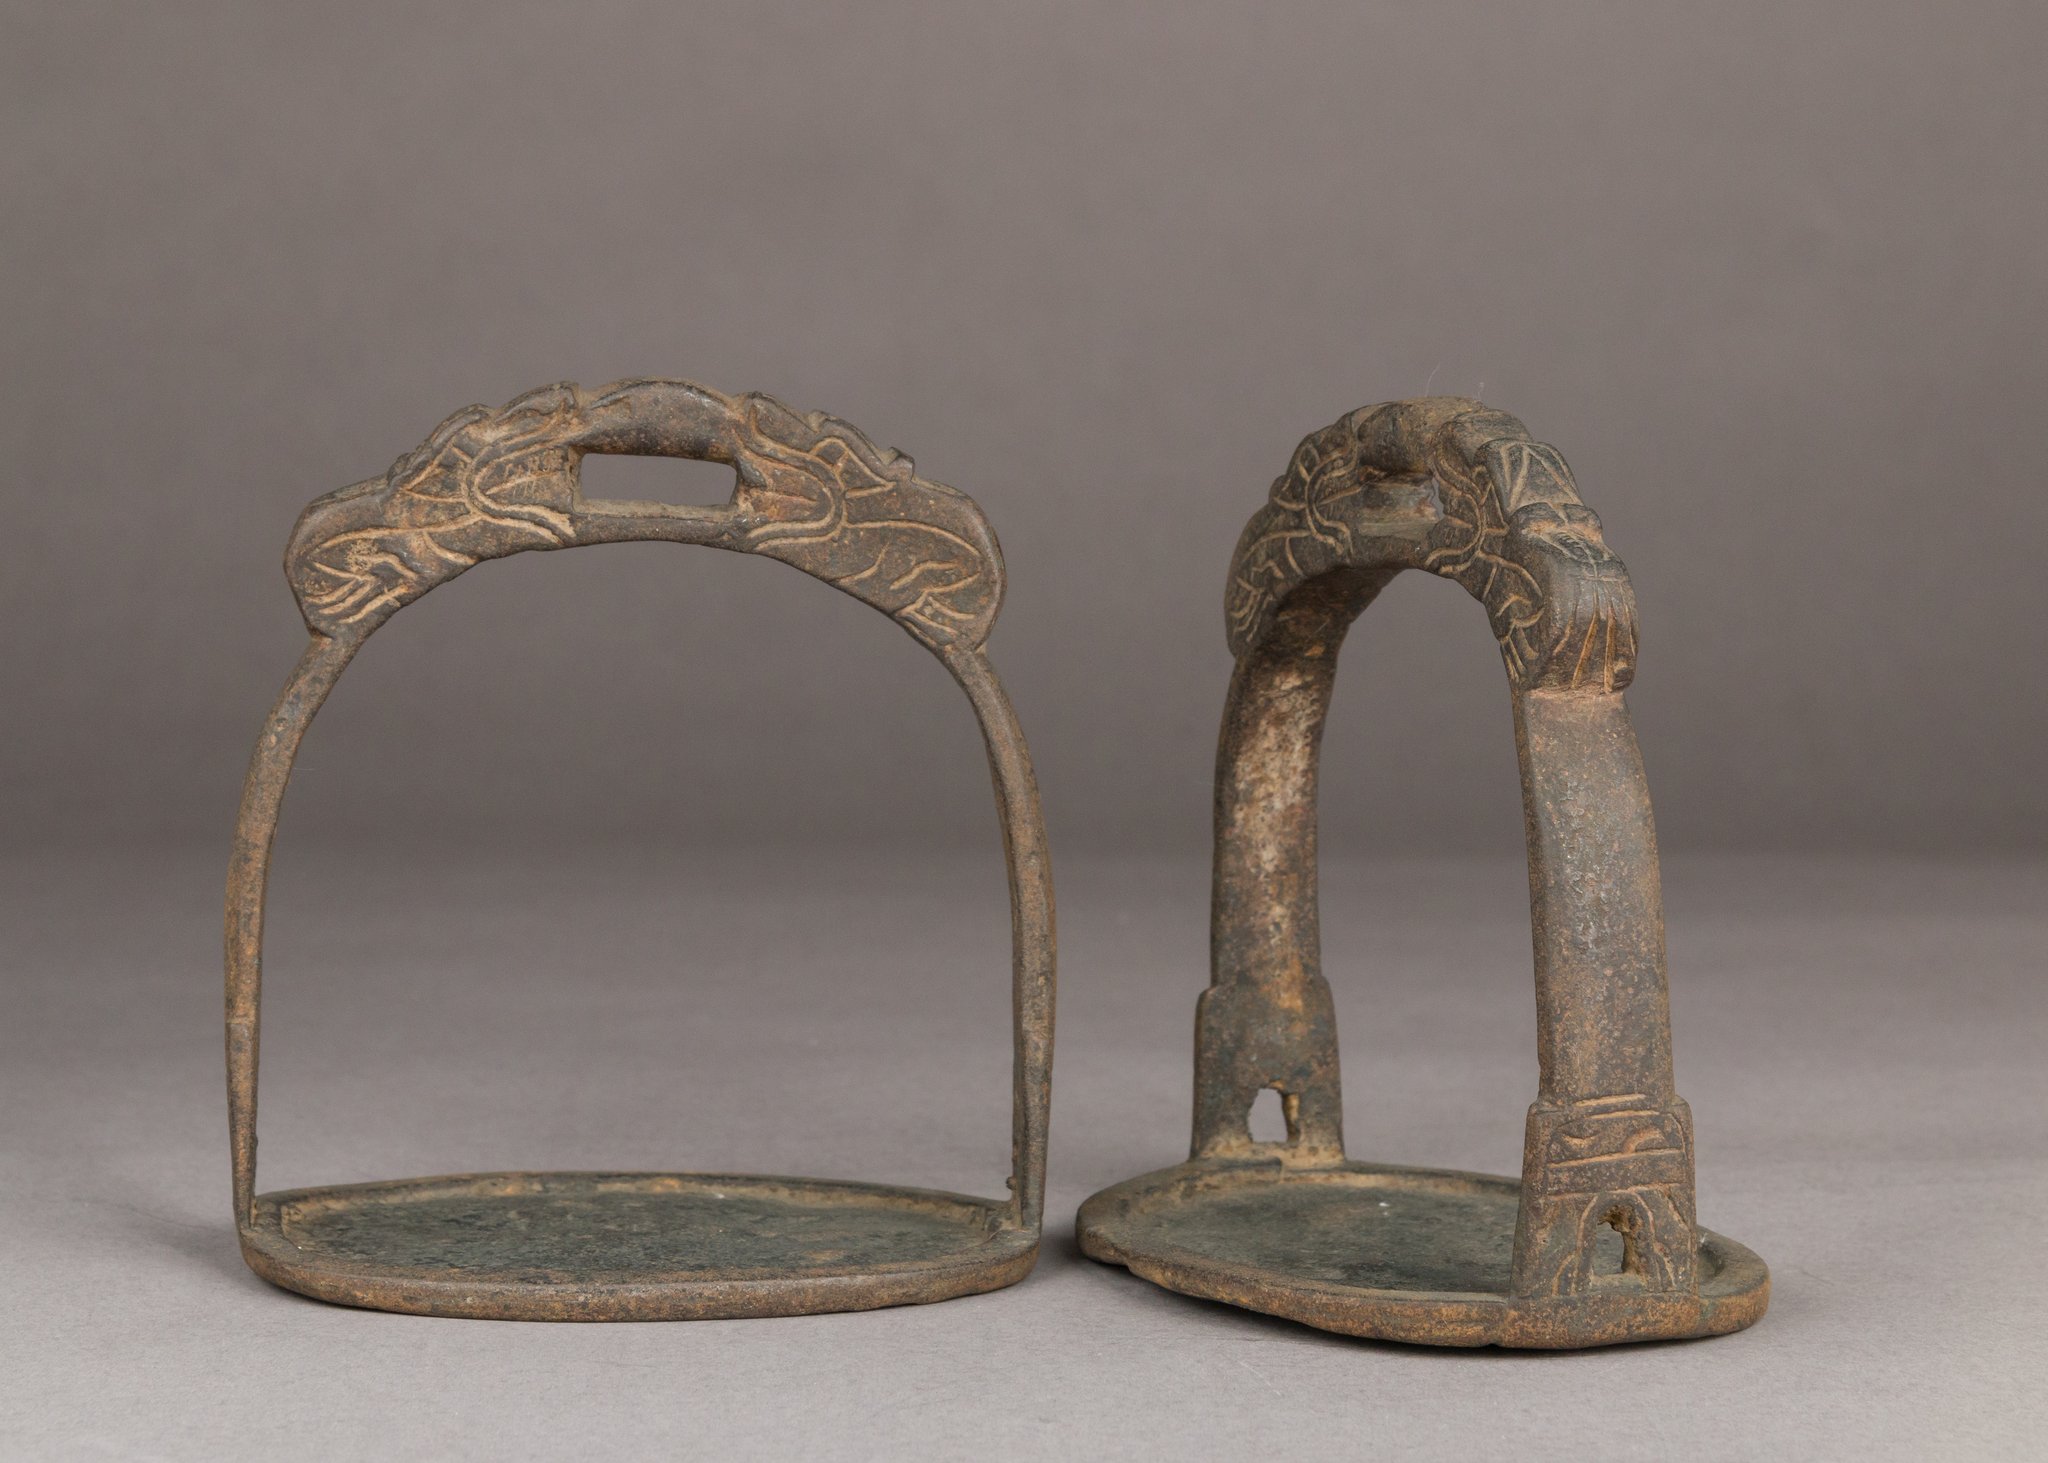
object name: pair of stirrup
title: Pair of Stirrups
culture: chinese or korean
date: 1801-1900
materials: bronze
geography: korea or china